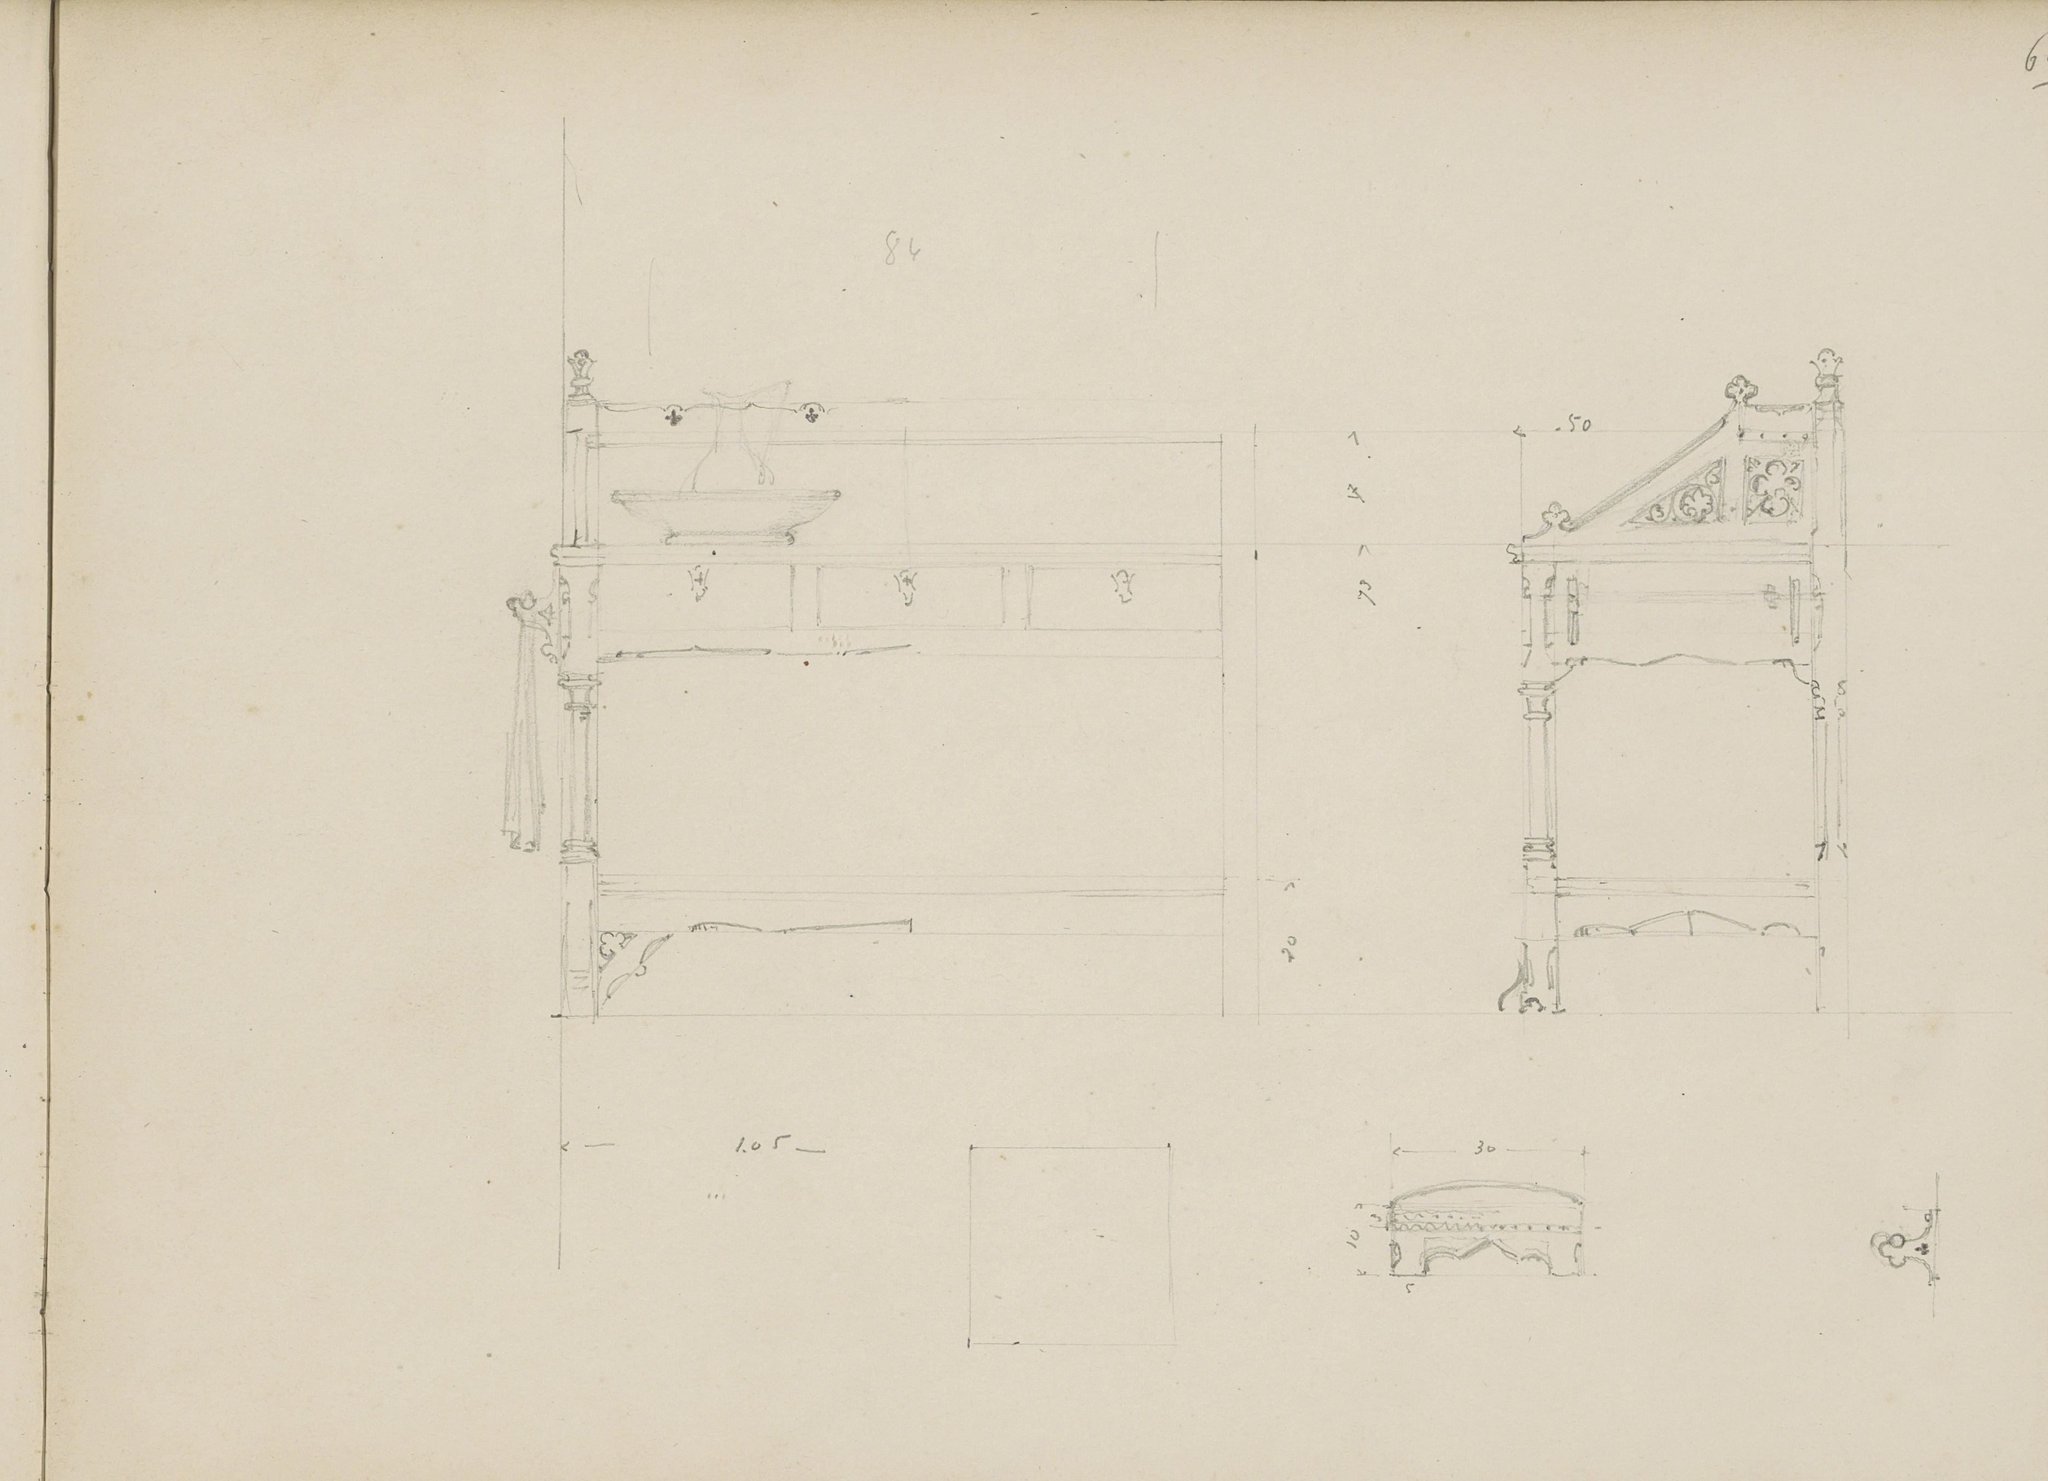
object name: sketchbook leaf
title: Voor- en zijaanzicht van een wastafel en een voetenbank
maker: pierre joseph hubert cuypers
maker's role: draughtsman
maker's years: 1827-1921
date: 1857-1859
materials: paper, pencil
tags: footstool, table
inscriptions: annotation: ‘[...]’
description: Blad 68 recto uit een schetsboek met 77 bladen.